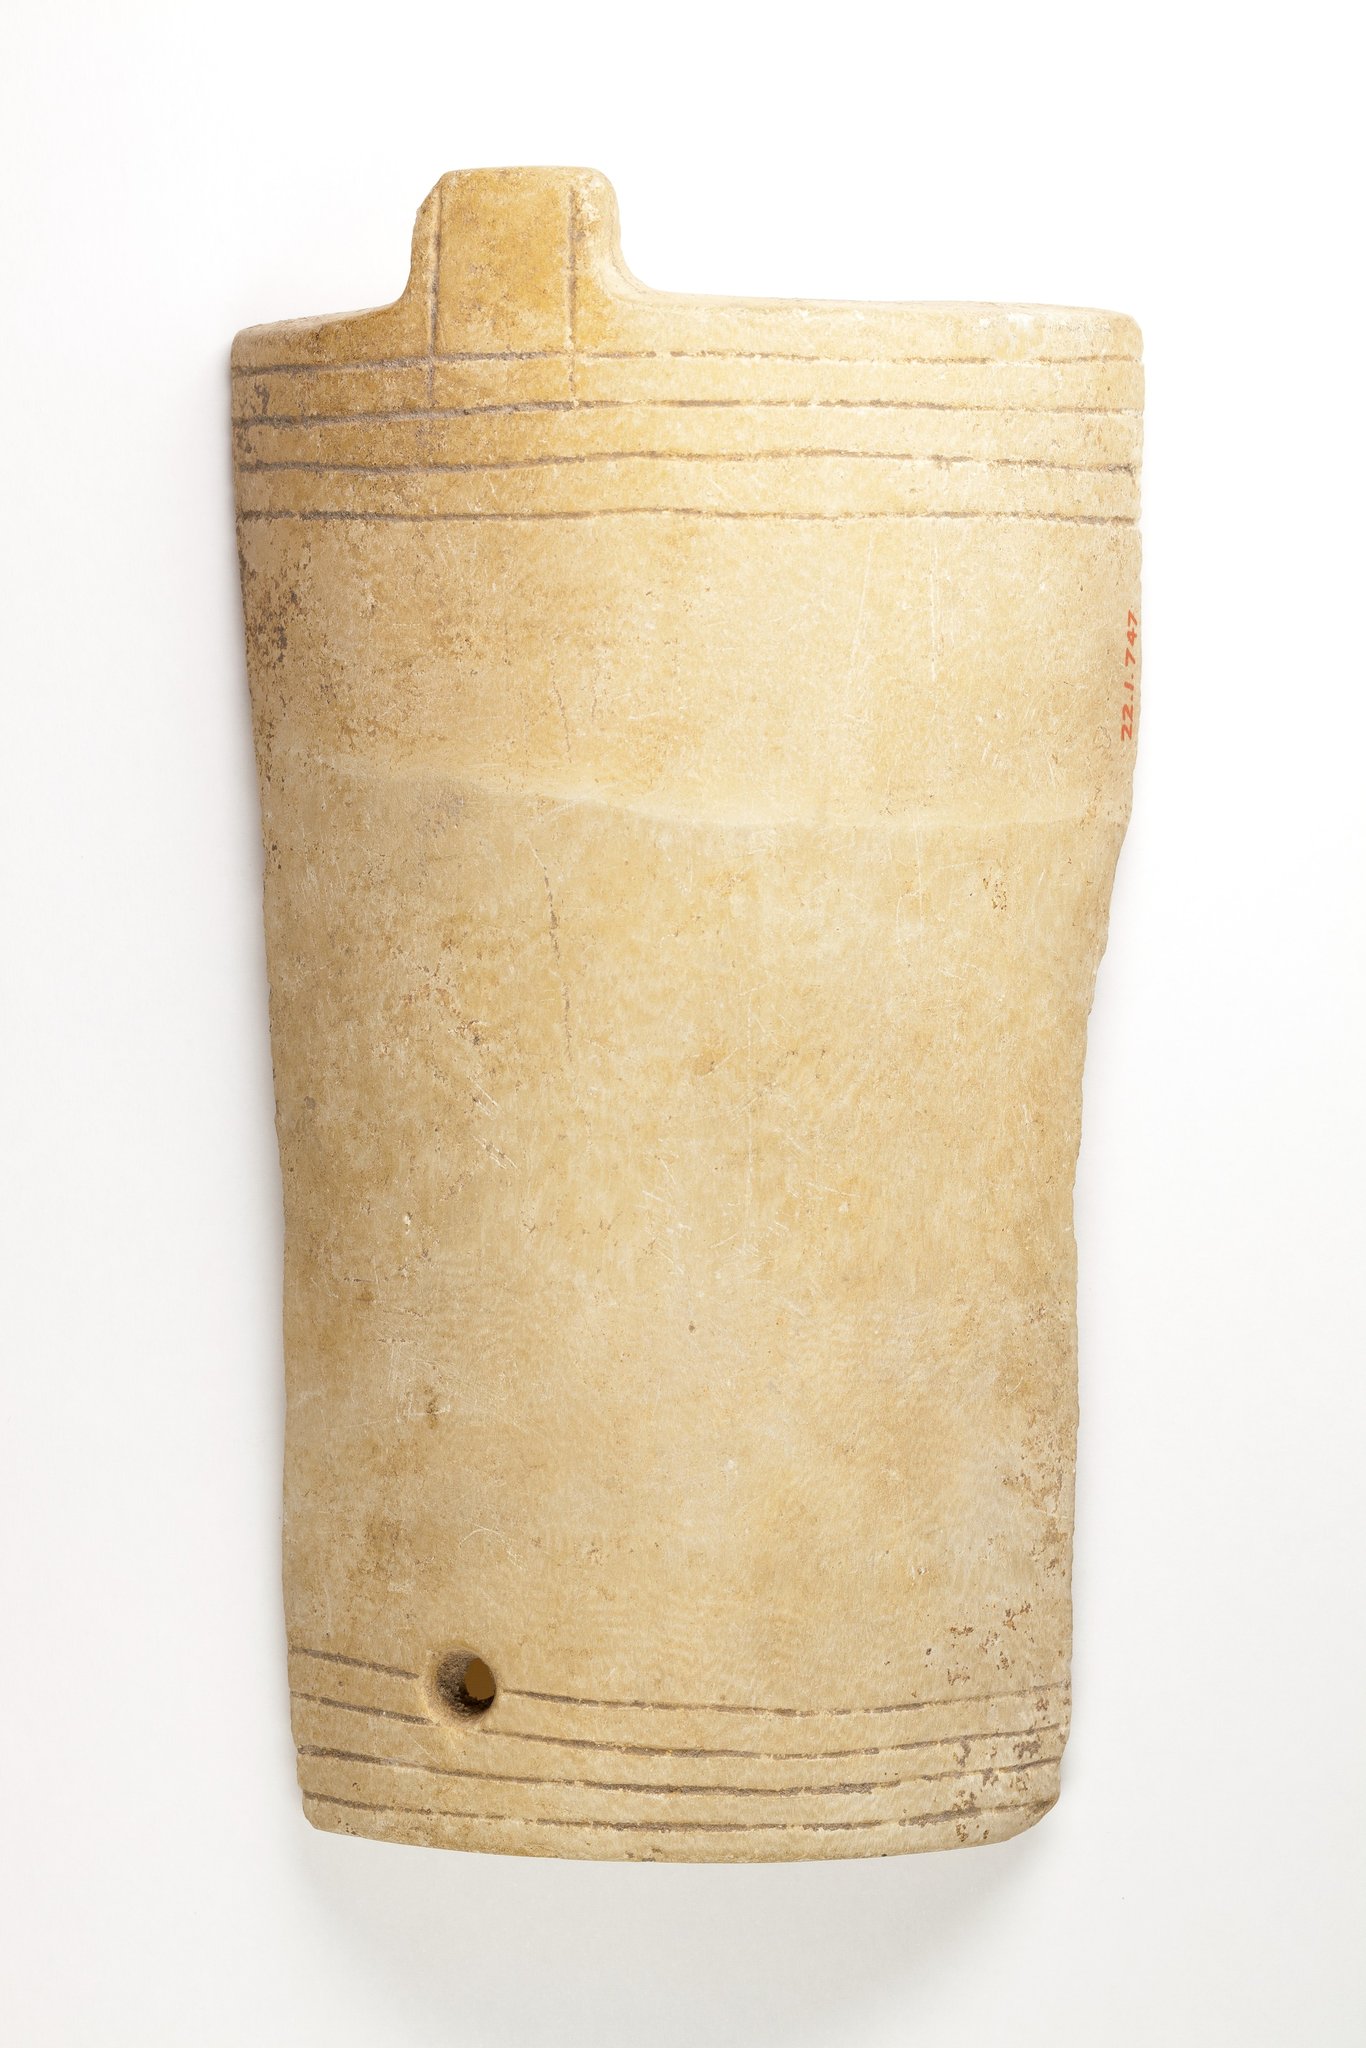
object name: fragment of a jar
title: Jar fragment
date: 1981-1640 BCE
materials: stone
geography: egypt